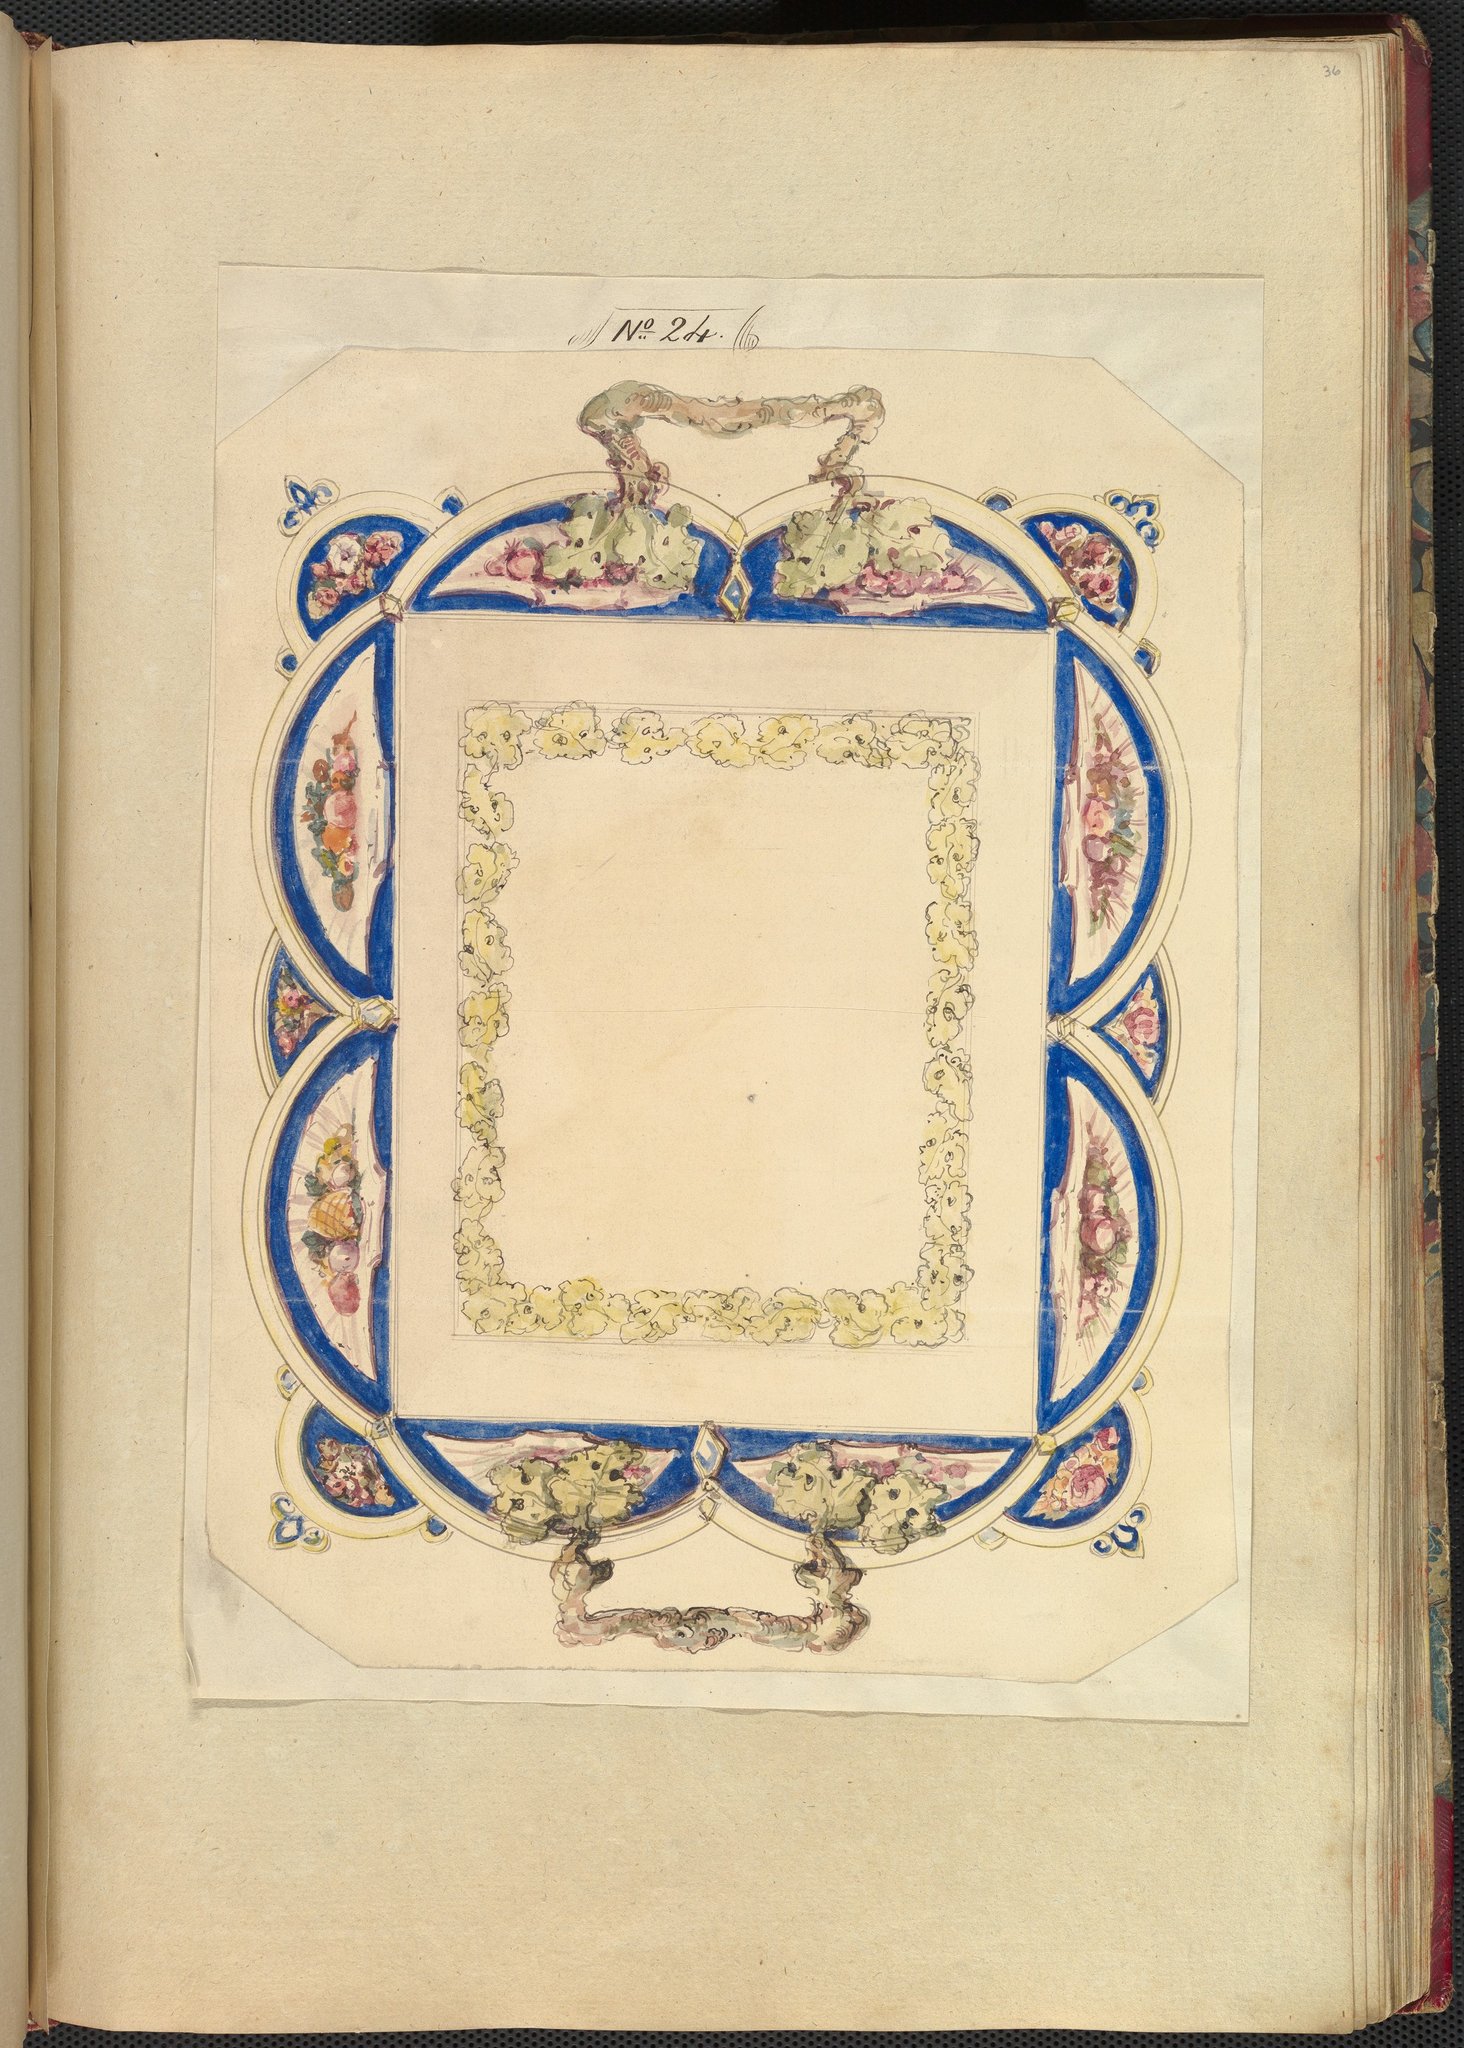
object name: drawing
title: Design for a Two-Handled Platter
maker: alfred henry forrester [alfred crowquill]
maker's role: artist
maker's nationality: british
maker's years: 1804-1872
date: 1845-1855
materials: ink, watercolor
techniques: pen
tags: flowers,dishes